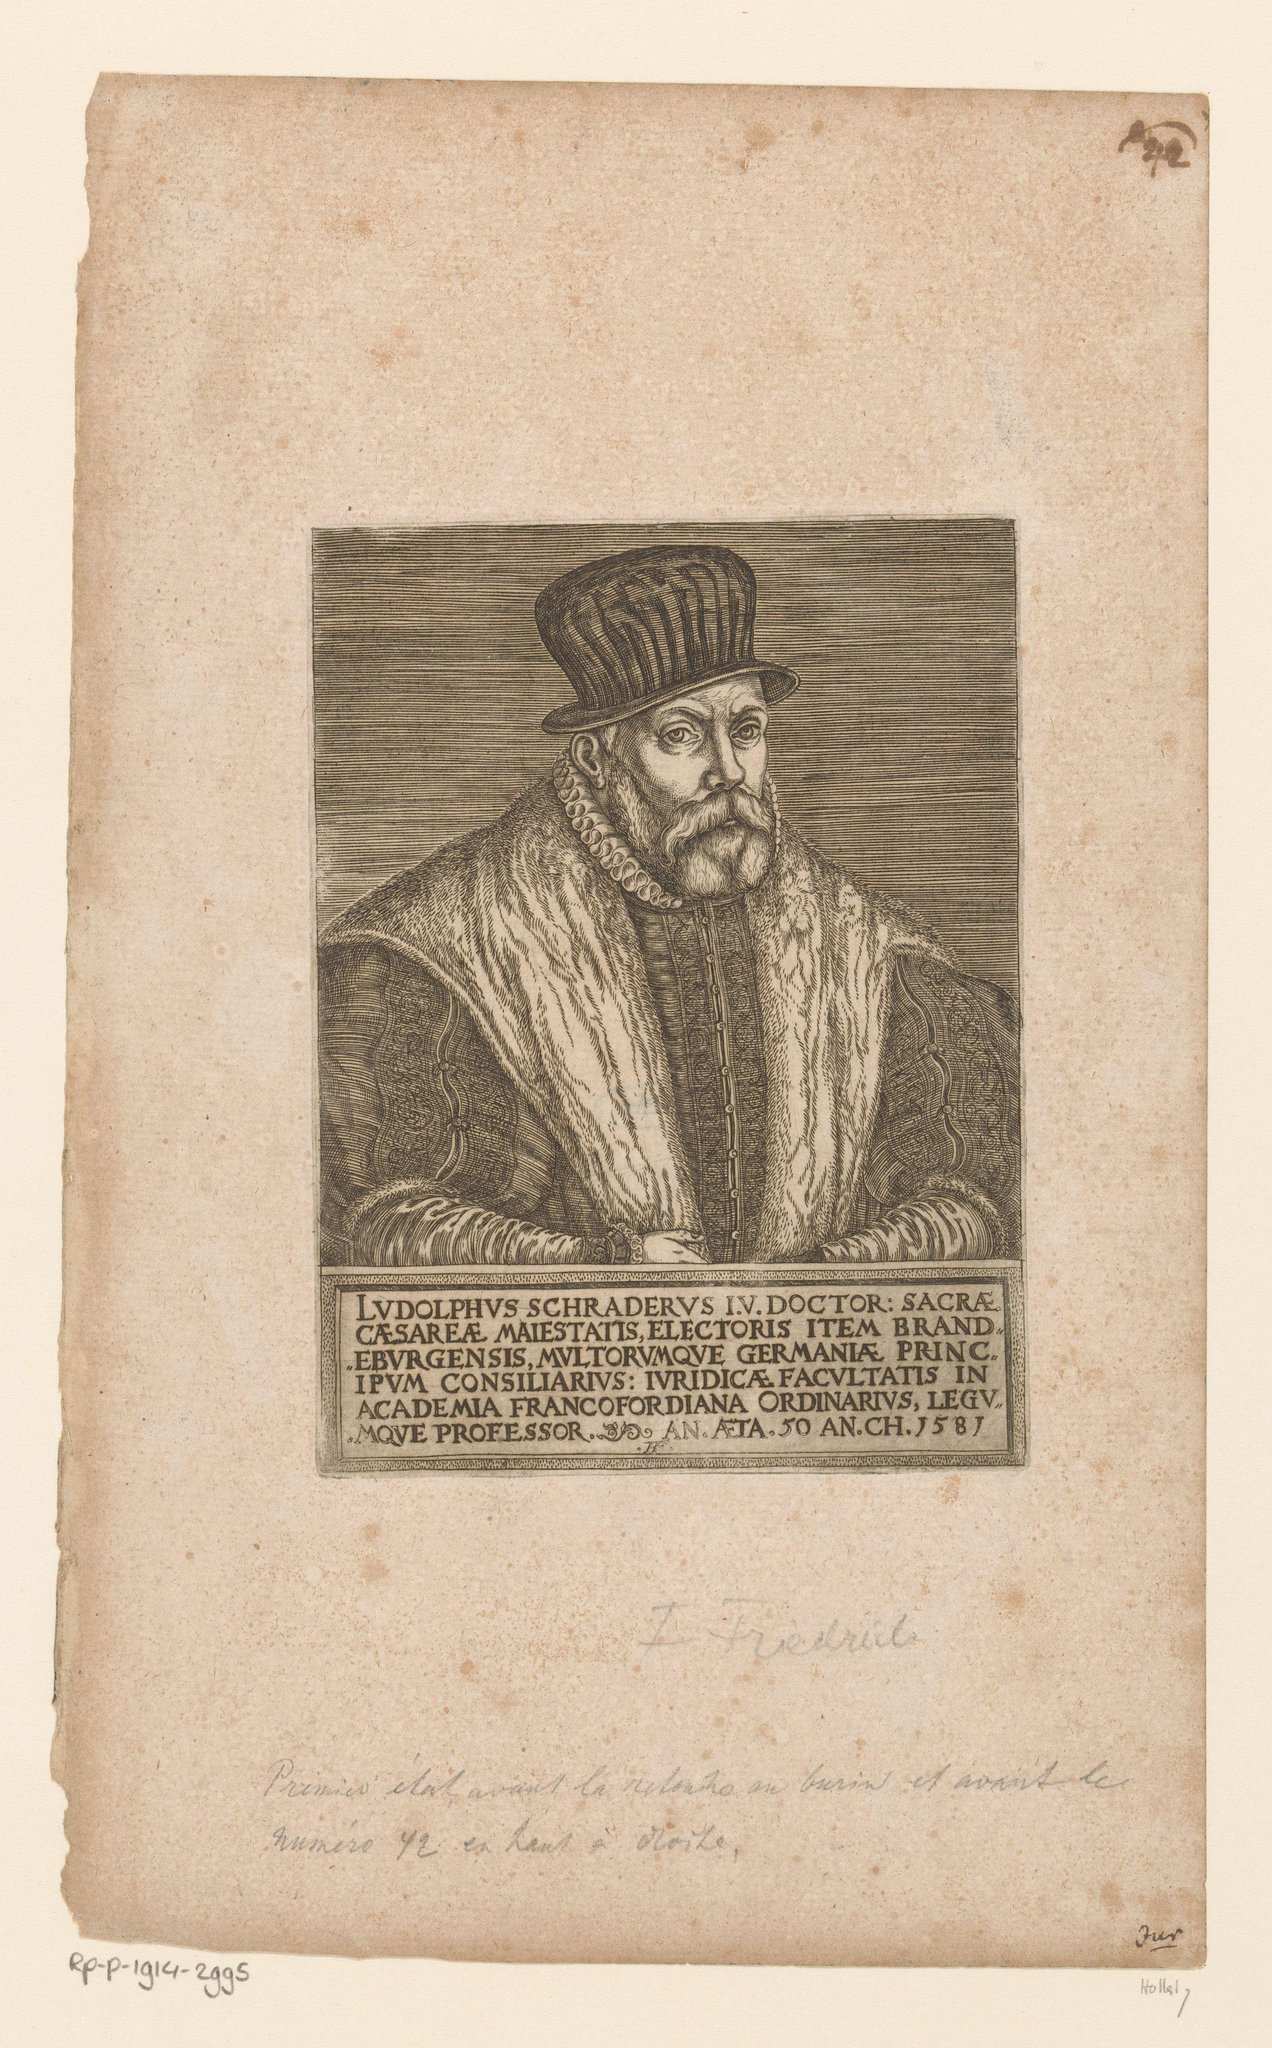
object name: print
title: Portret van Ludolf Schrader op 50-jarige leeftijd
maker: franz friedrich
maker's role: print maker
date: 1581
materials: paper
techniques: engraving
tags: historical persons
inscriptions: collector's mark: Lugt 2228